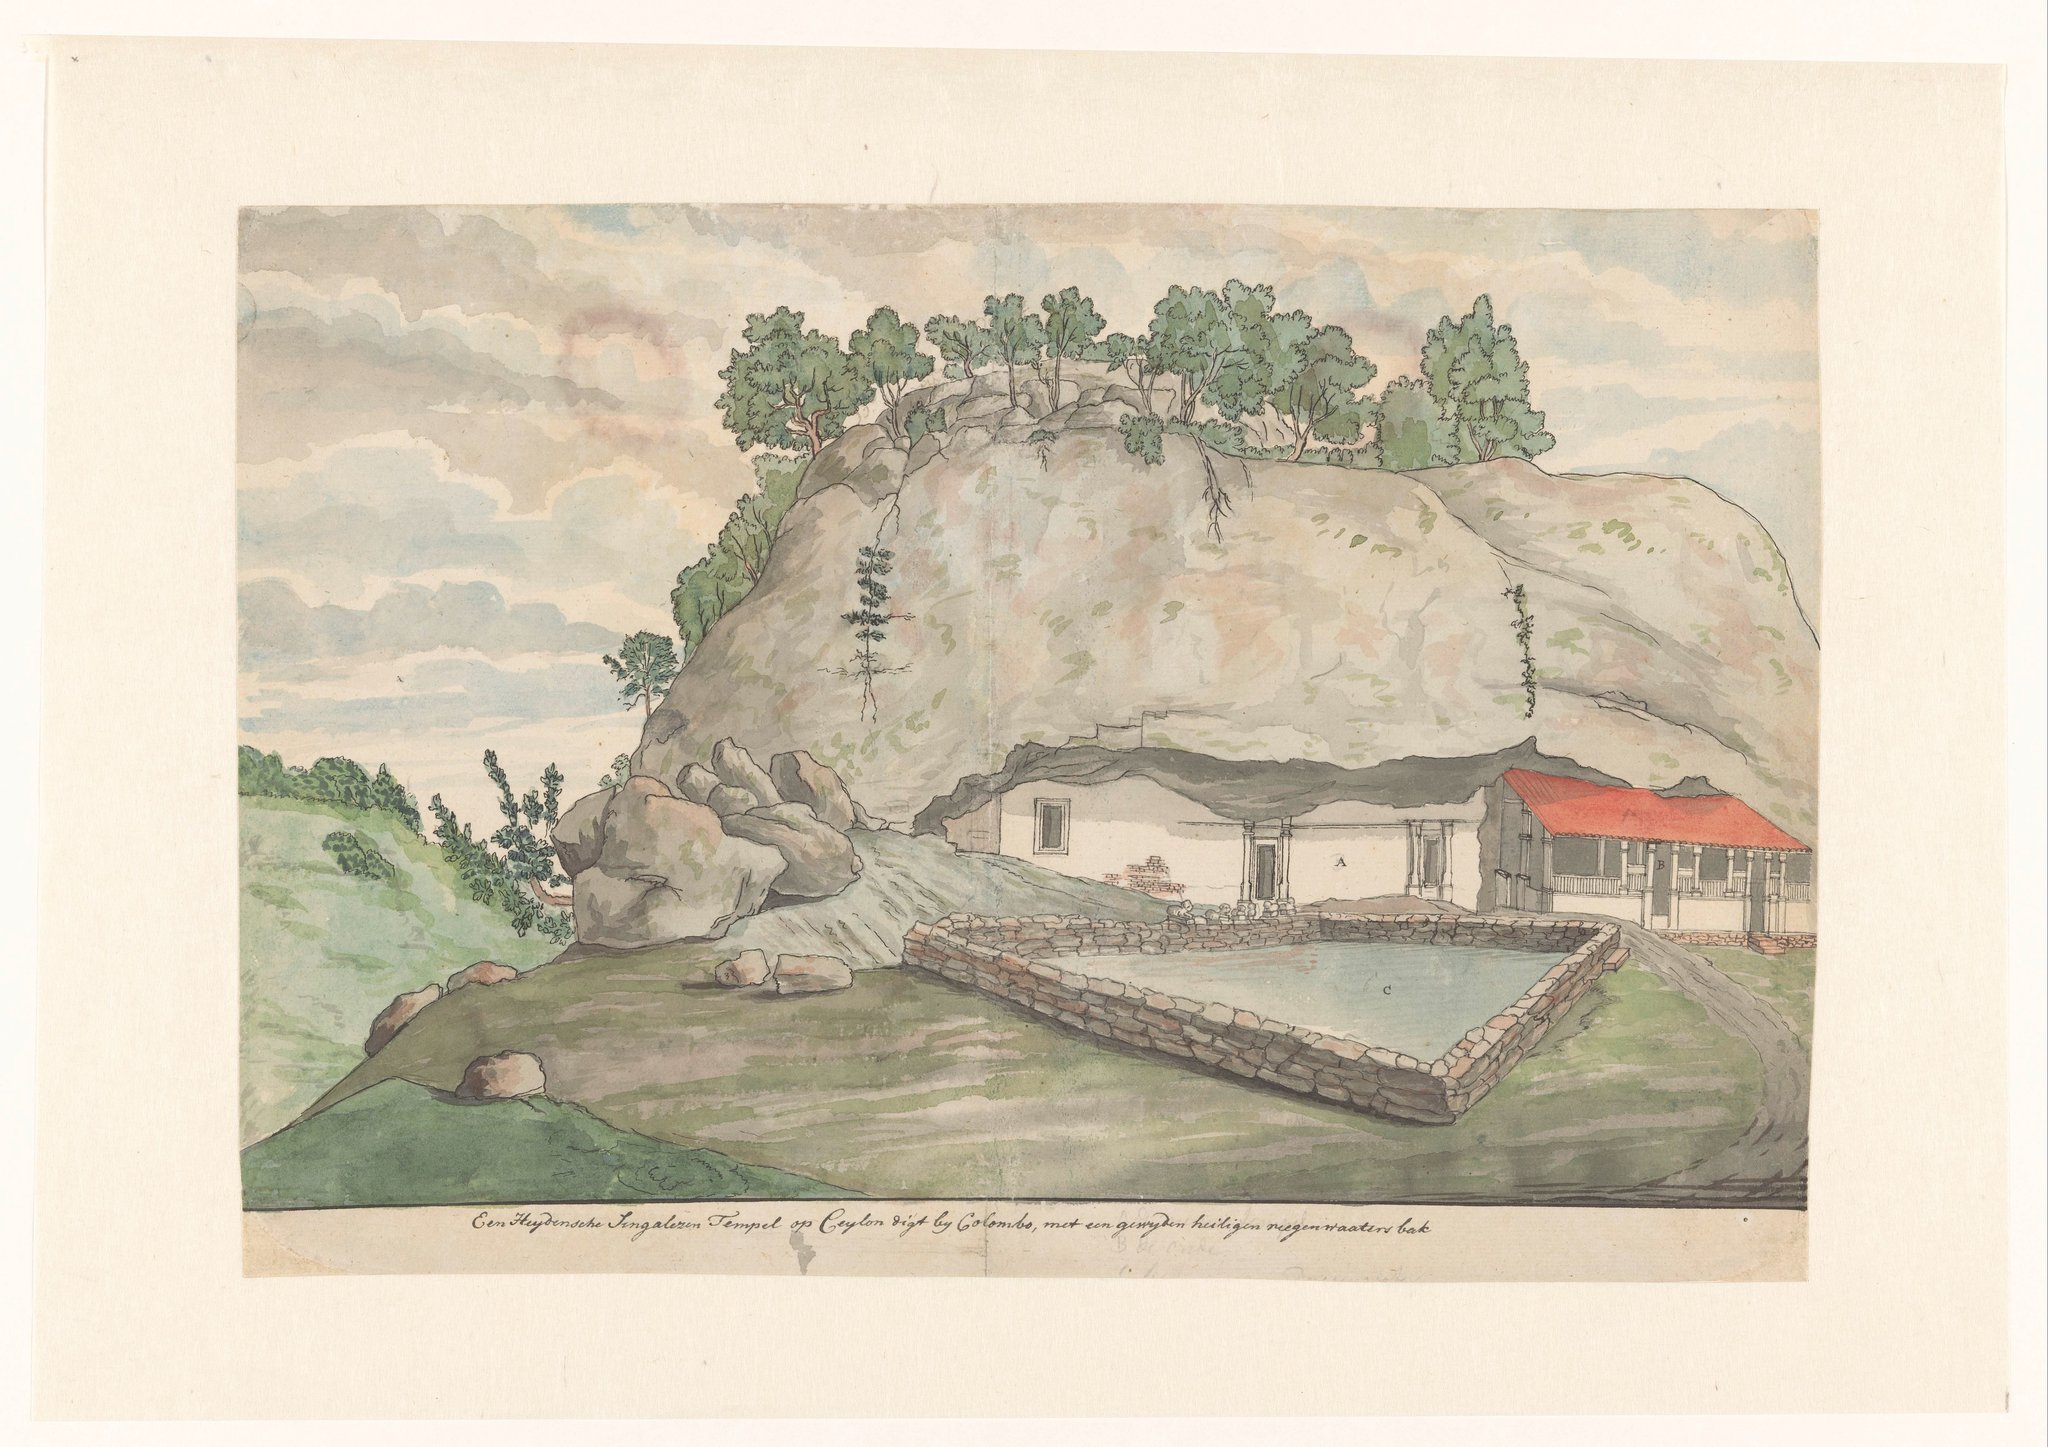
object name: drawing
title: Adam's Berg (Mulkirigala), Entrance to the Image Rooms Hewn into the Rocks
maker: jan brandes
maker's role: draughtsman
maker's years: 1743-1808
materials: ink, paper, pencil, watercolor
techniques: brush, pen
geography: sri lanka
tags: places and objects of worship ~ hinduism, buddhism, jainism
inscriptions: inscription: ‘Een Heydensche Singalezen Tempel op Ceylon digt bij Colombo, met een gewyden heiligen reegenwaaters bak’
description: Boeddhistisch heiligdom op Ceylon, bij Mulgirigala. Gebouwen onder een rots, een boeddhistische grot, bij een waterbassin. Met opschrift.